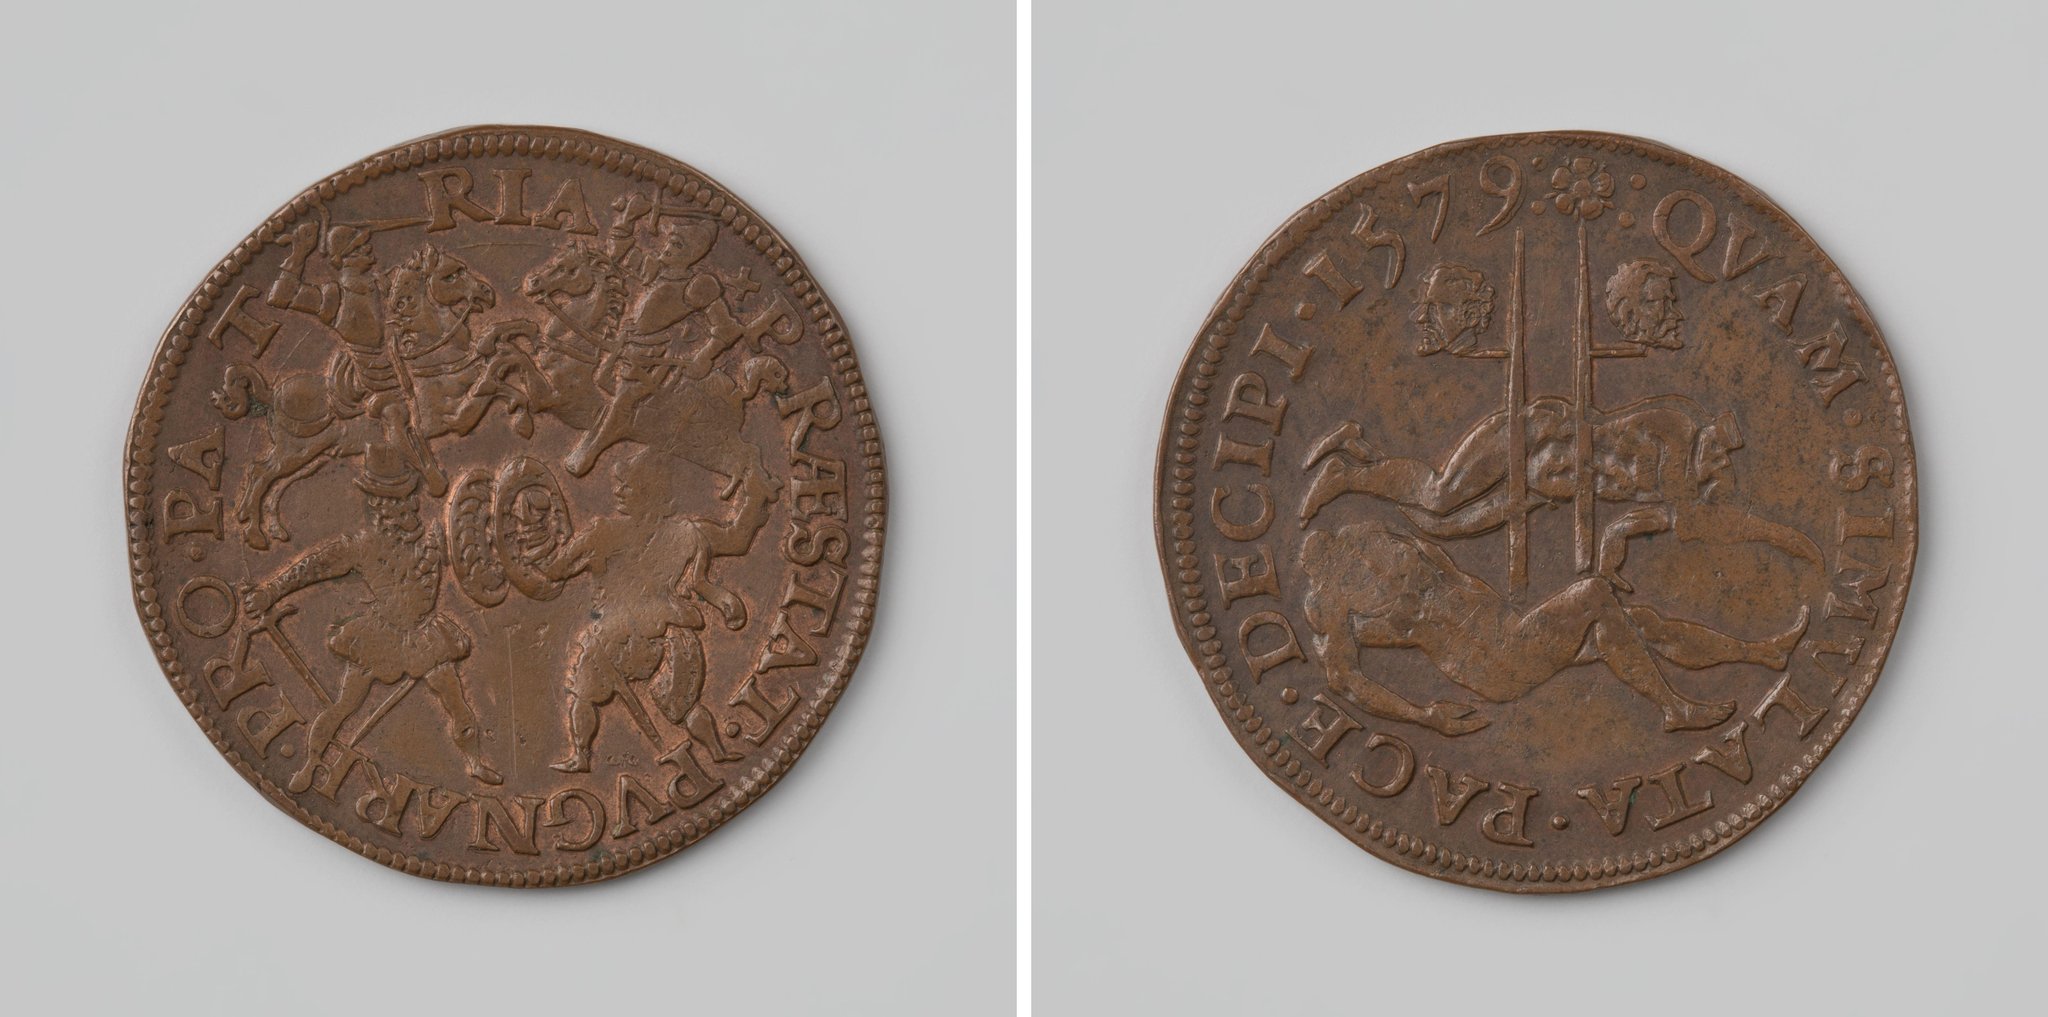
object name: jeton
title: Waarschuwing tegen de vredesonderhandelingen te Keulen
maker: gerard van bylaer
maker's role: die cutter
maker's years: 1540-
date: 1579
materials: copper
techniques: striking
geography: dordrecht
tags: brussels, earl, cologne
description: Koperen penning. Voorzijde: twee ruiters en twee soldaten te voet met elkaar in gevecht binnen omschrift. Keerzijde: twee lijken, waarvan de hoofden op staken zijn geplaatst binnen omschrift